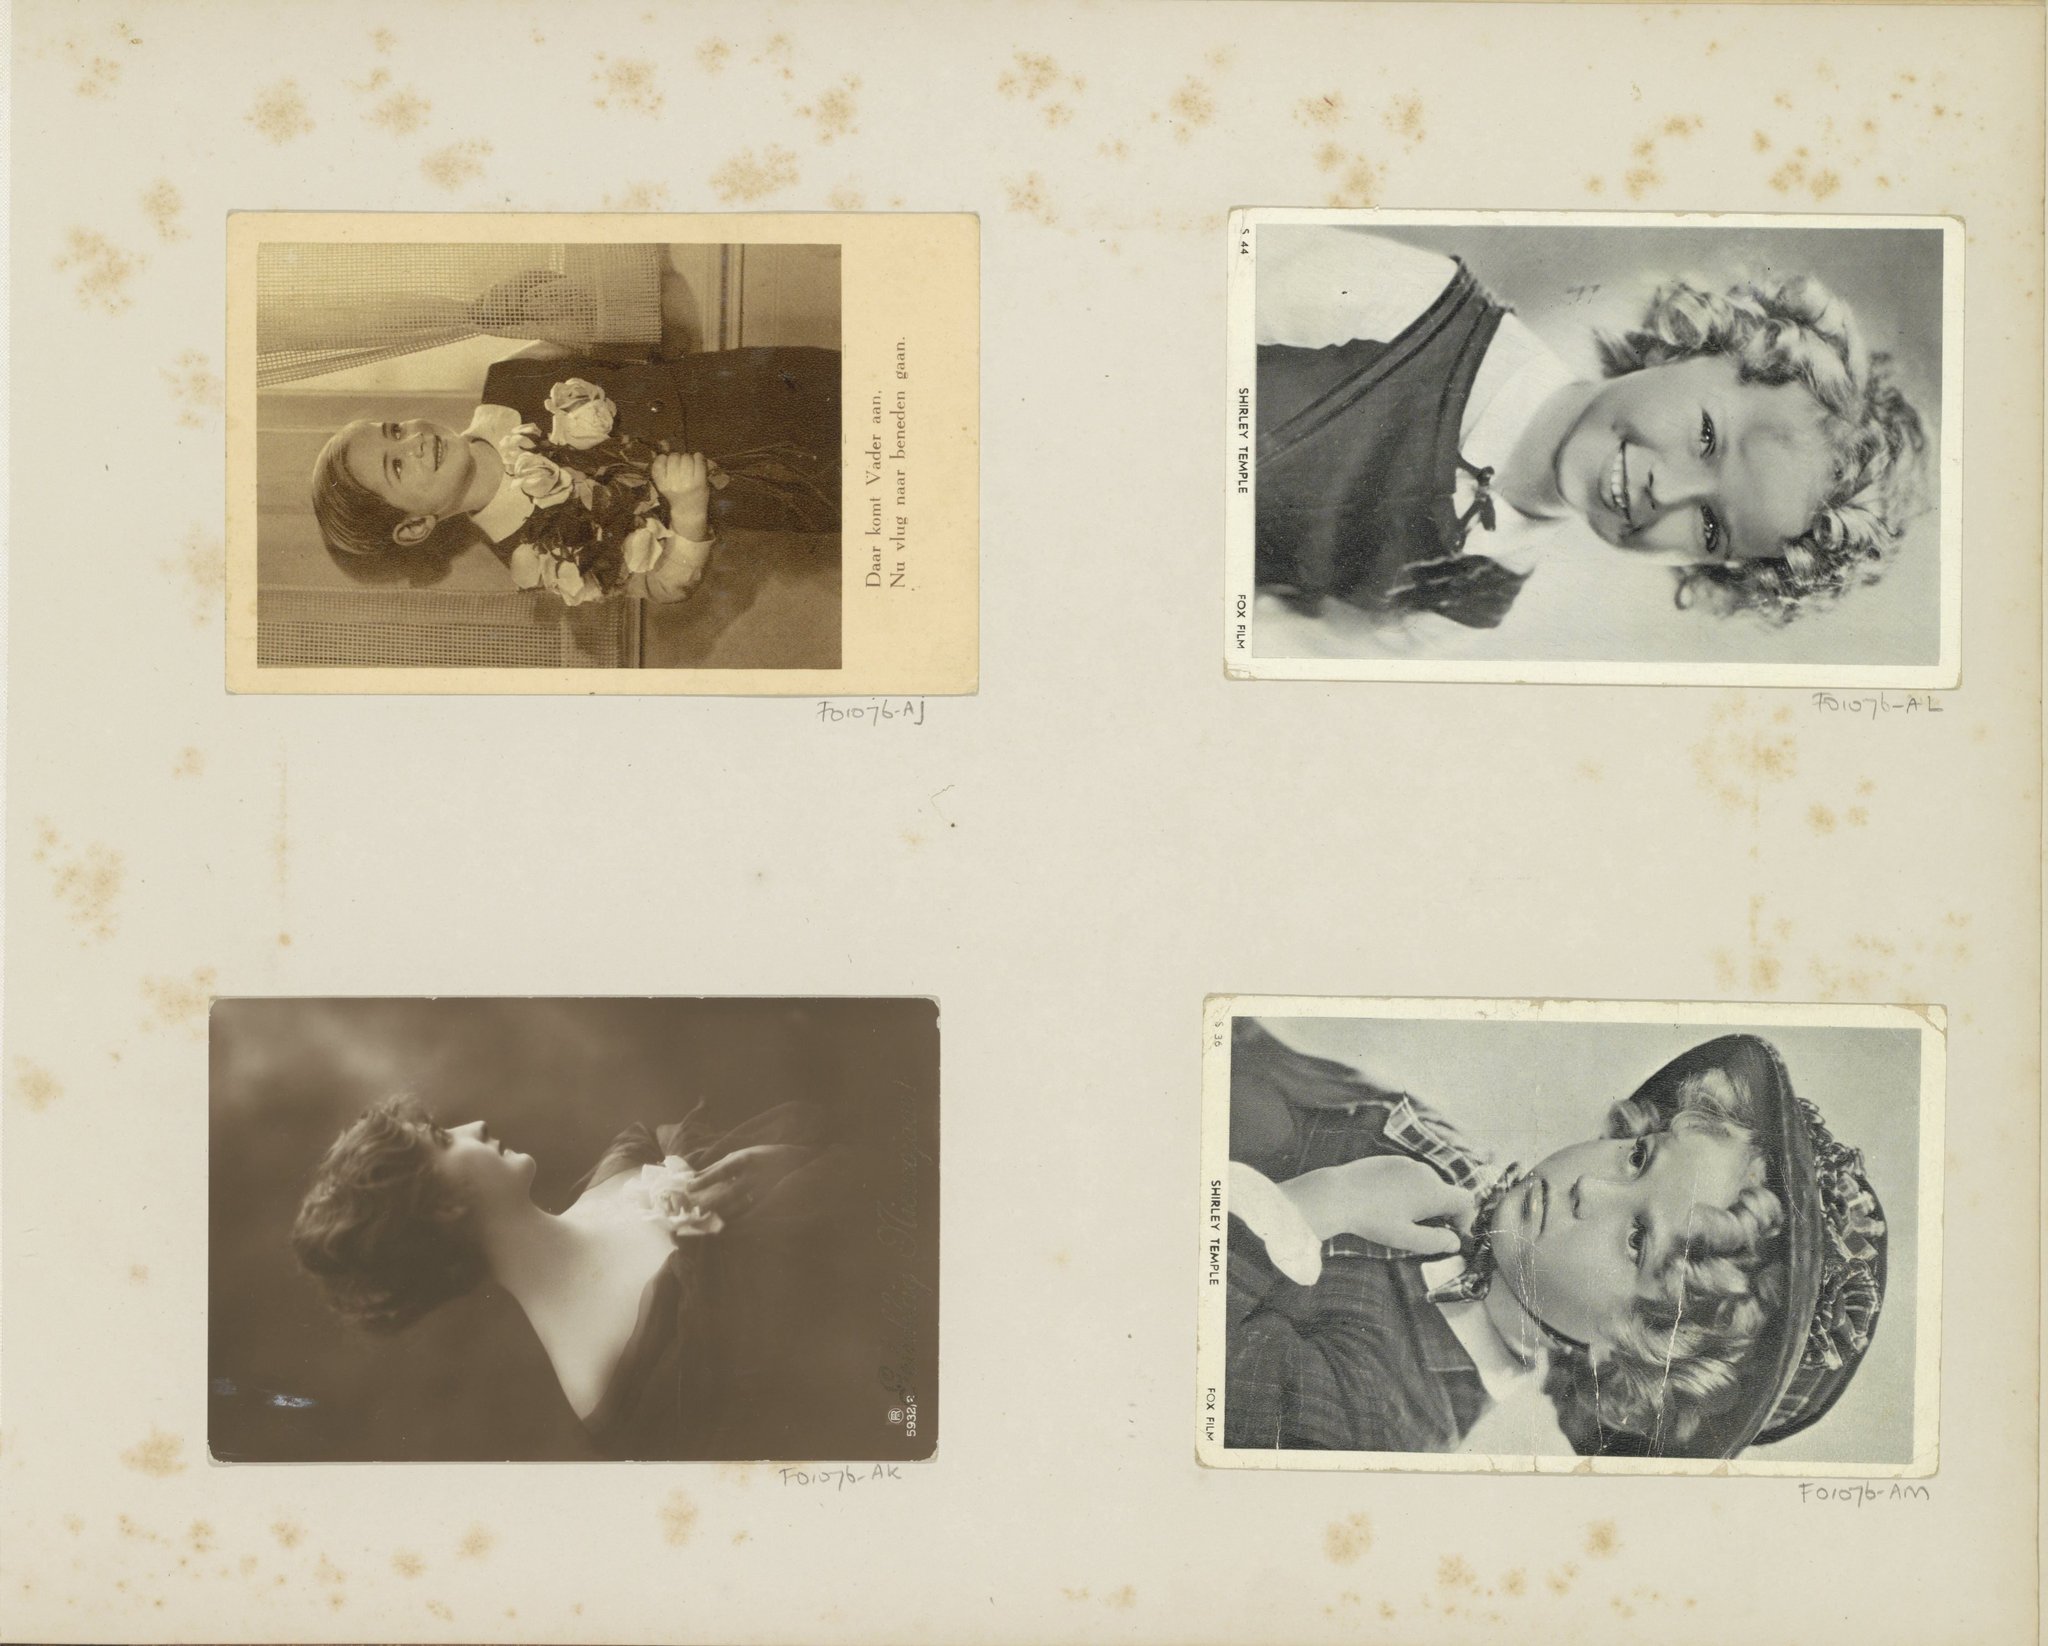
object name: photograph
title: Nieuwjaarskaart met een portret van vrouw met een corsage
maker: Anonymous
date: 1930-1940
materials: cardboard, paper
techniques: gelatin silver print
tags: adult woman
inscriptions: monogram: ‘Rph’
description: Onderdeel van Album met foto's van spoorwegen in Nederlands-Indië en prentbriefkaarten.